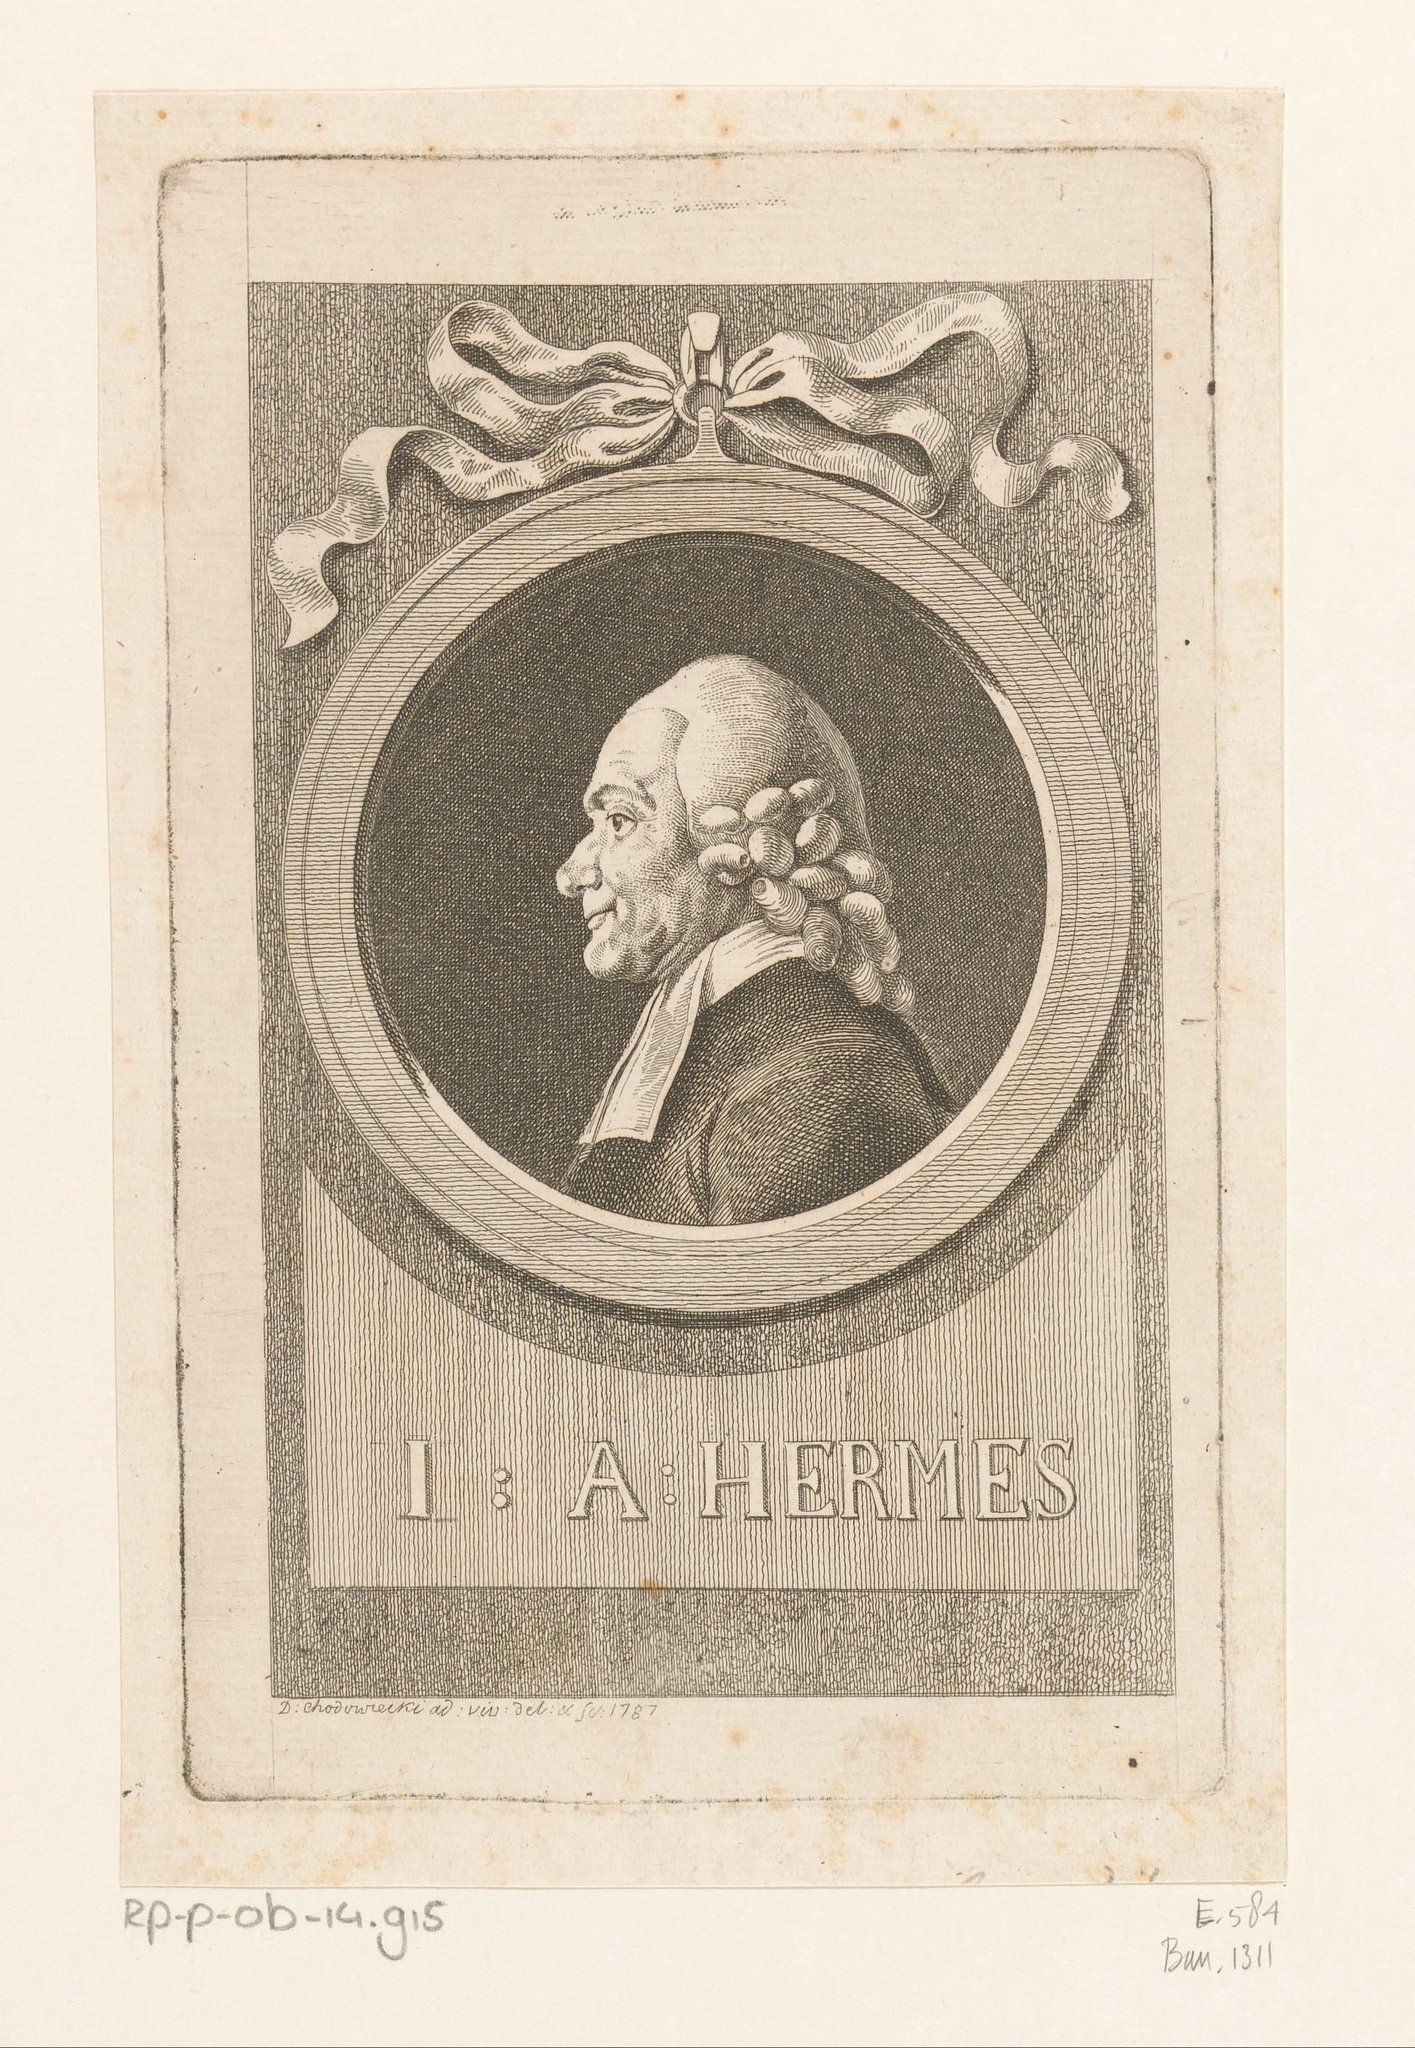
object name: print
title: Portret van Johann August Hermes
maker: daniel nikolaus chodowiecki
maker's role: draughtsman, print maker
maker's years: 1726-1801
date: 1787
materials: paper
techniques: etching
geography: berlin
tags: ornament ~ medallion, historical persons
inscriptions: collector's mark: Lugt 2228